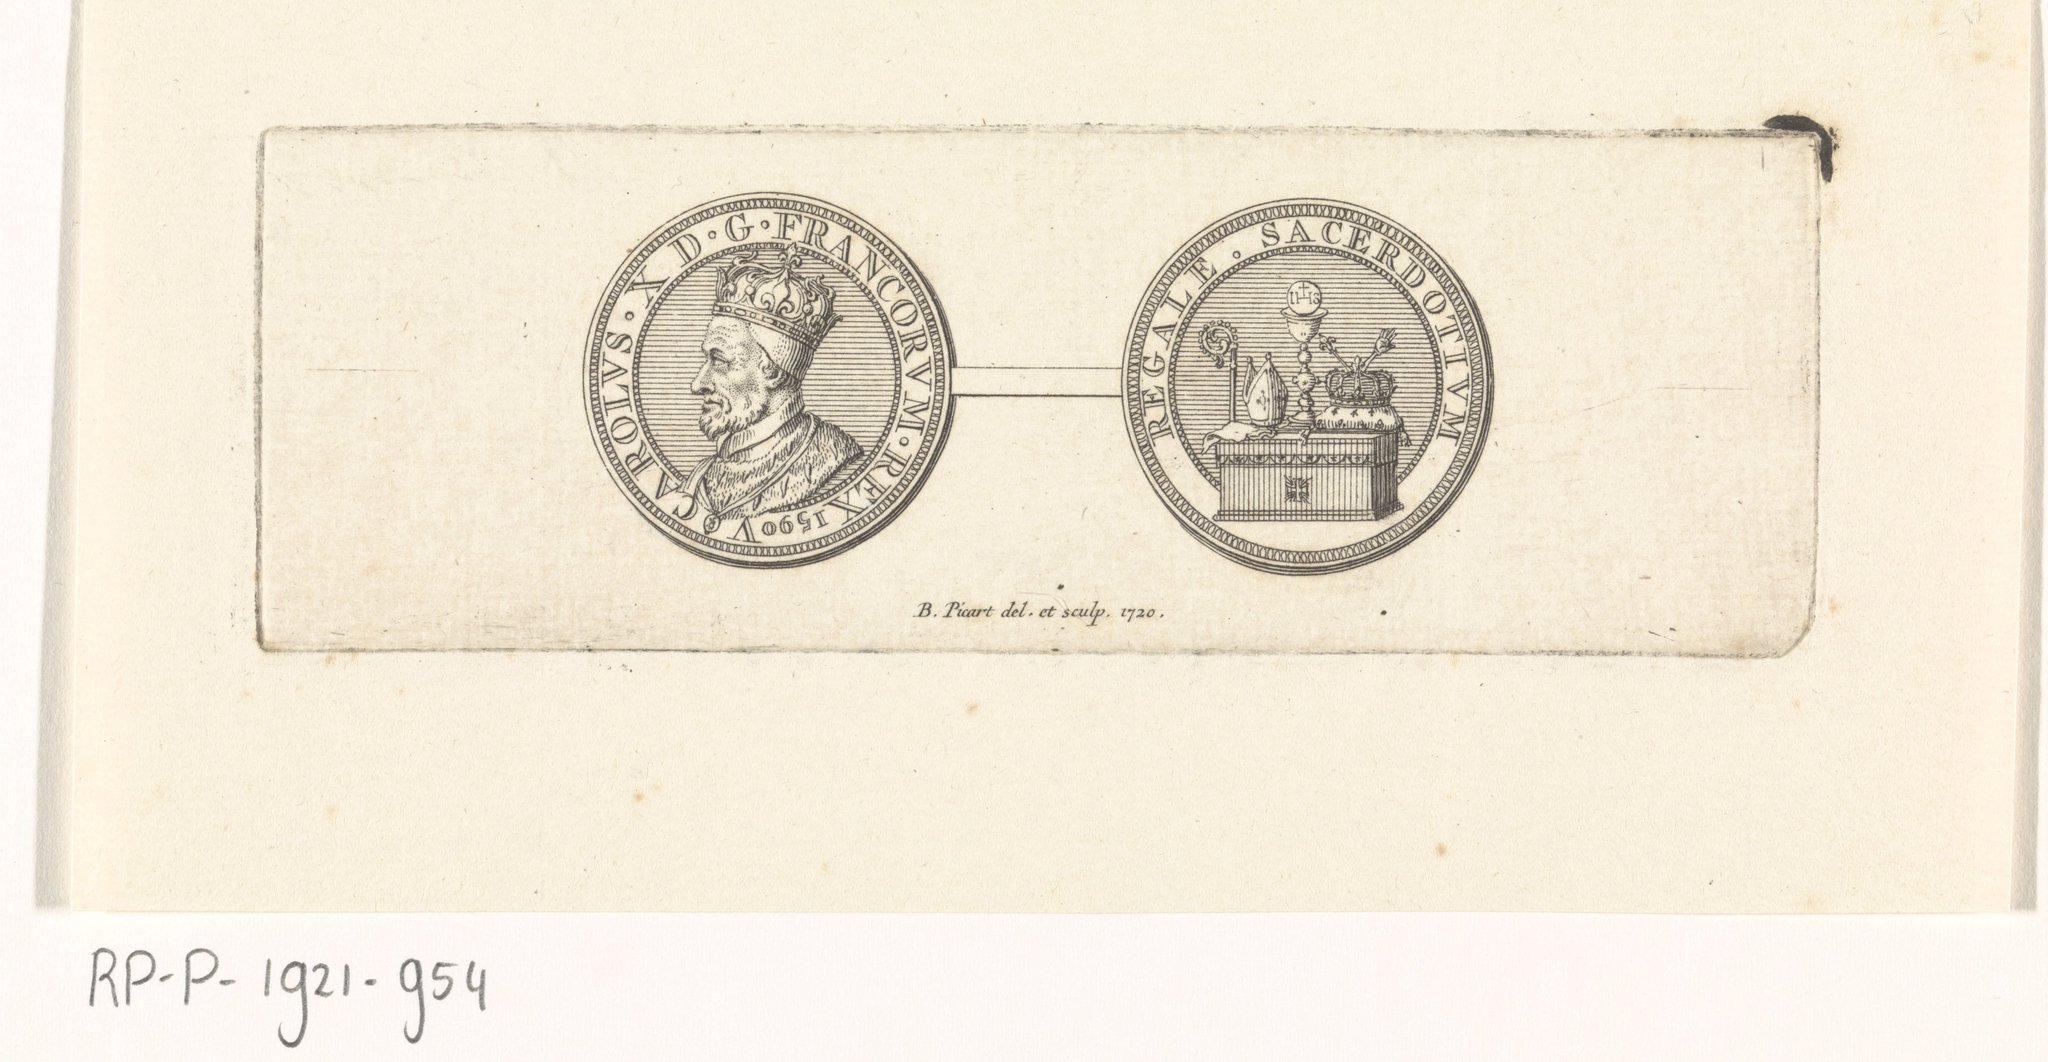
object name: print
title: Penning met het portret van Karel X van Frankrijk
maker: bernard picart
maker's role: draughtsman, print maker, publisher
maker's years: 1673-1733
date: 1720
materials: paper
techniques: engraving, etching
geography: amsterdam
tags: france, charles ii de bourbon-vendôme, crown (symbol of sovereignty), insignia of bishop, e.g. mitre, crozier, medal (considered as a piece of sculpture, regardless of its specific function)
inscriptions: collector's mark: Lugt 2228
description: Penning met het portret van Karel van Bourbon Vendome, kardinaal en aartsbisschop van Rouen. Hij trad tijdelijk op als koning Karel X. Op de andere zijde een altaar waarop een ciborie, geflankeerd door de bisschopsmijter en de kroon.